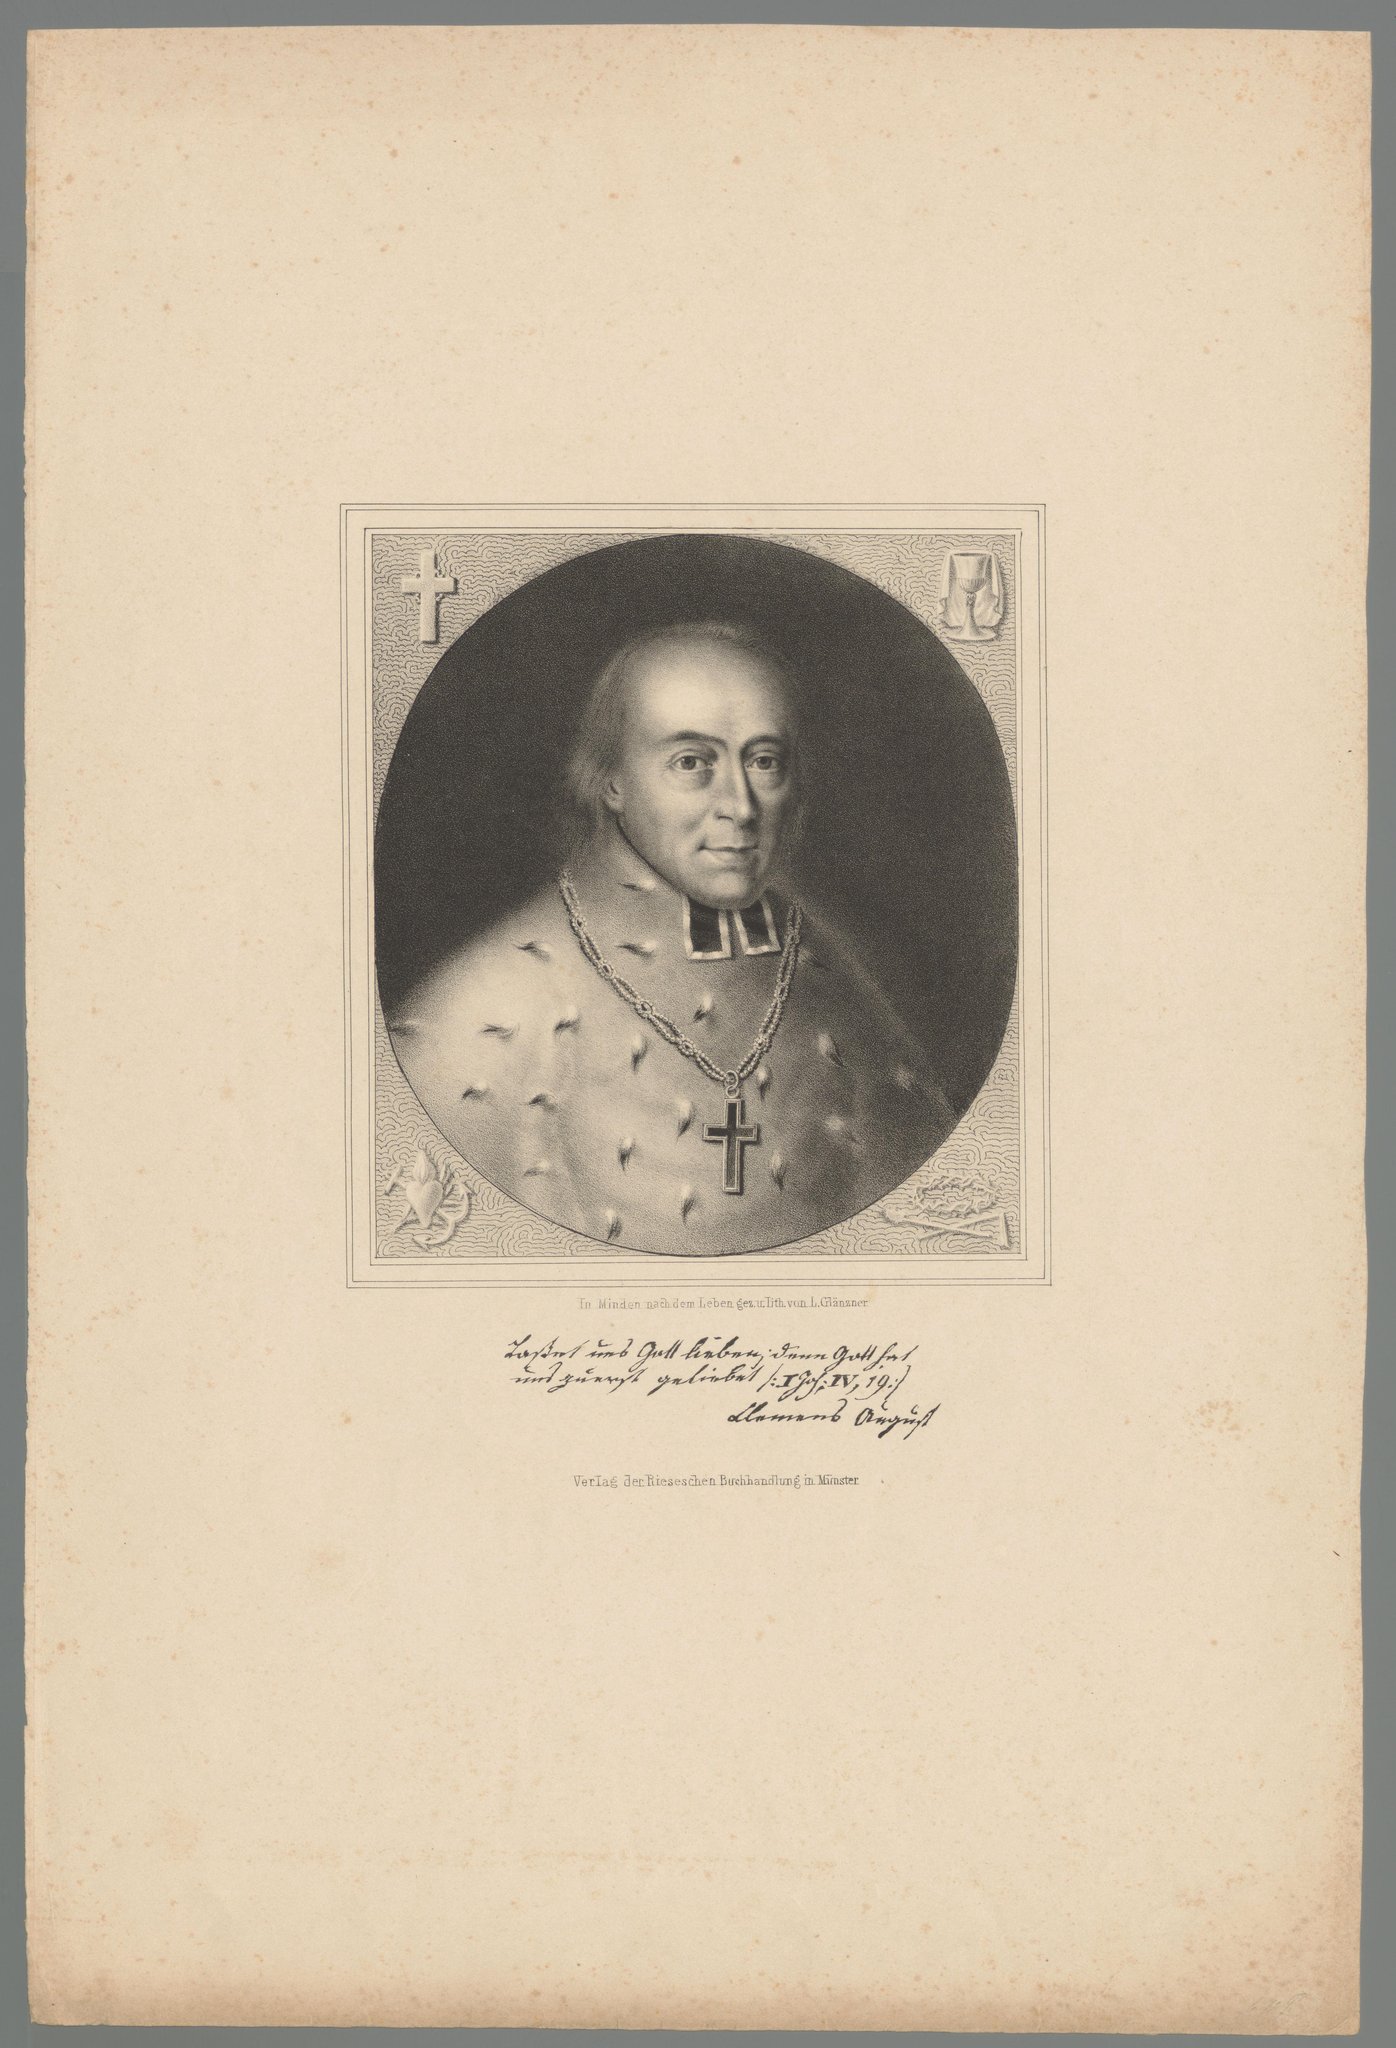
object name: print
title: Portret van Clemens August von Bayern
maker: ludwig glänzner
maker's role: print maker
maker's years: 1811-1887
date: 1821-1887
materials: paper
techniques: lithograph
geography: munster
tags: adult man, historical persons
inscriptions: collector's mark: Lugt 2228